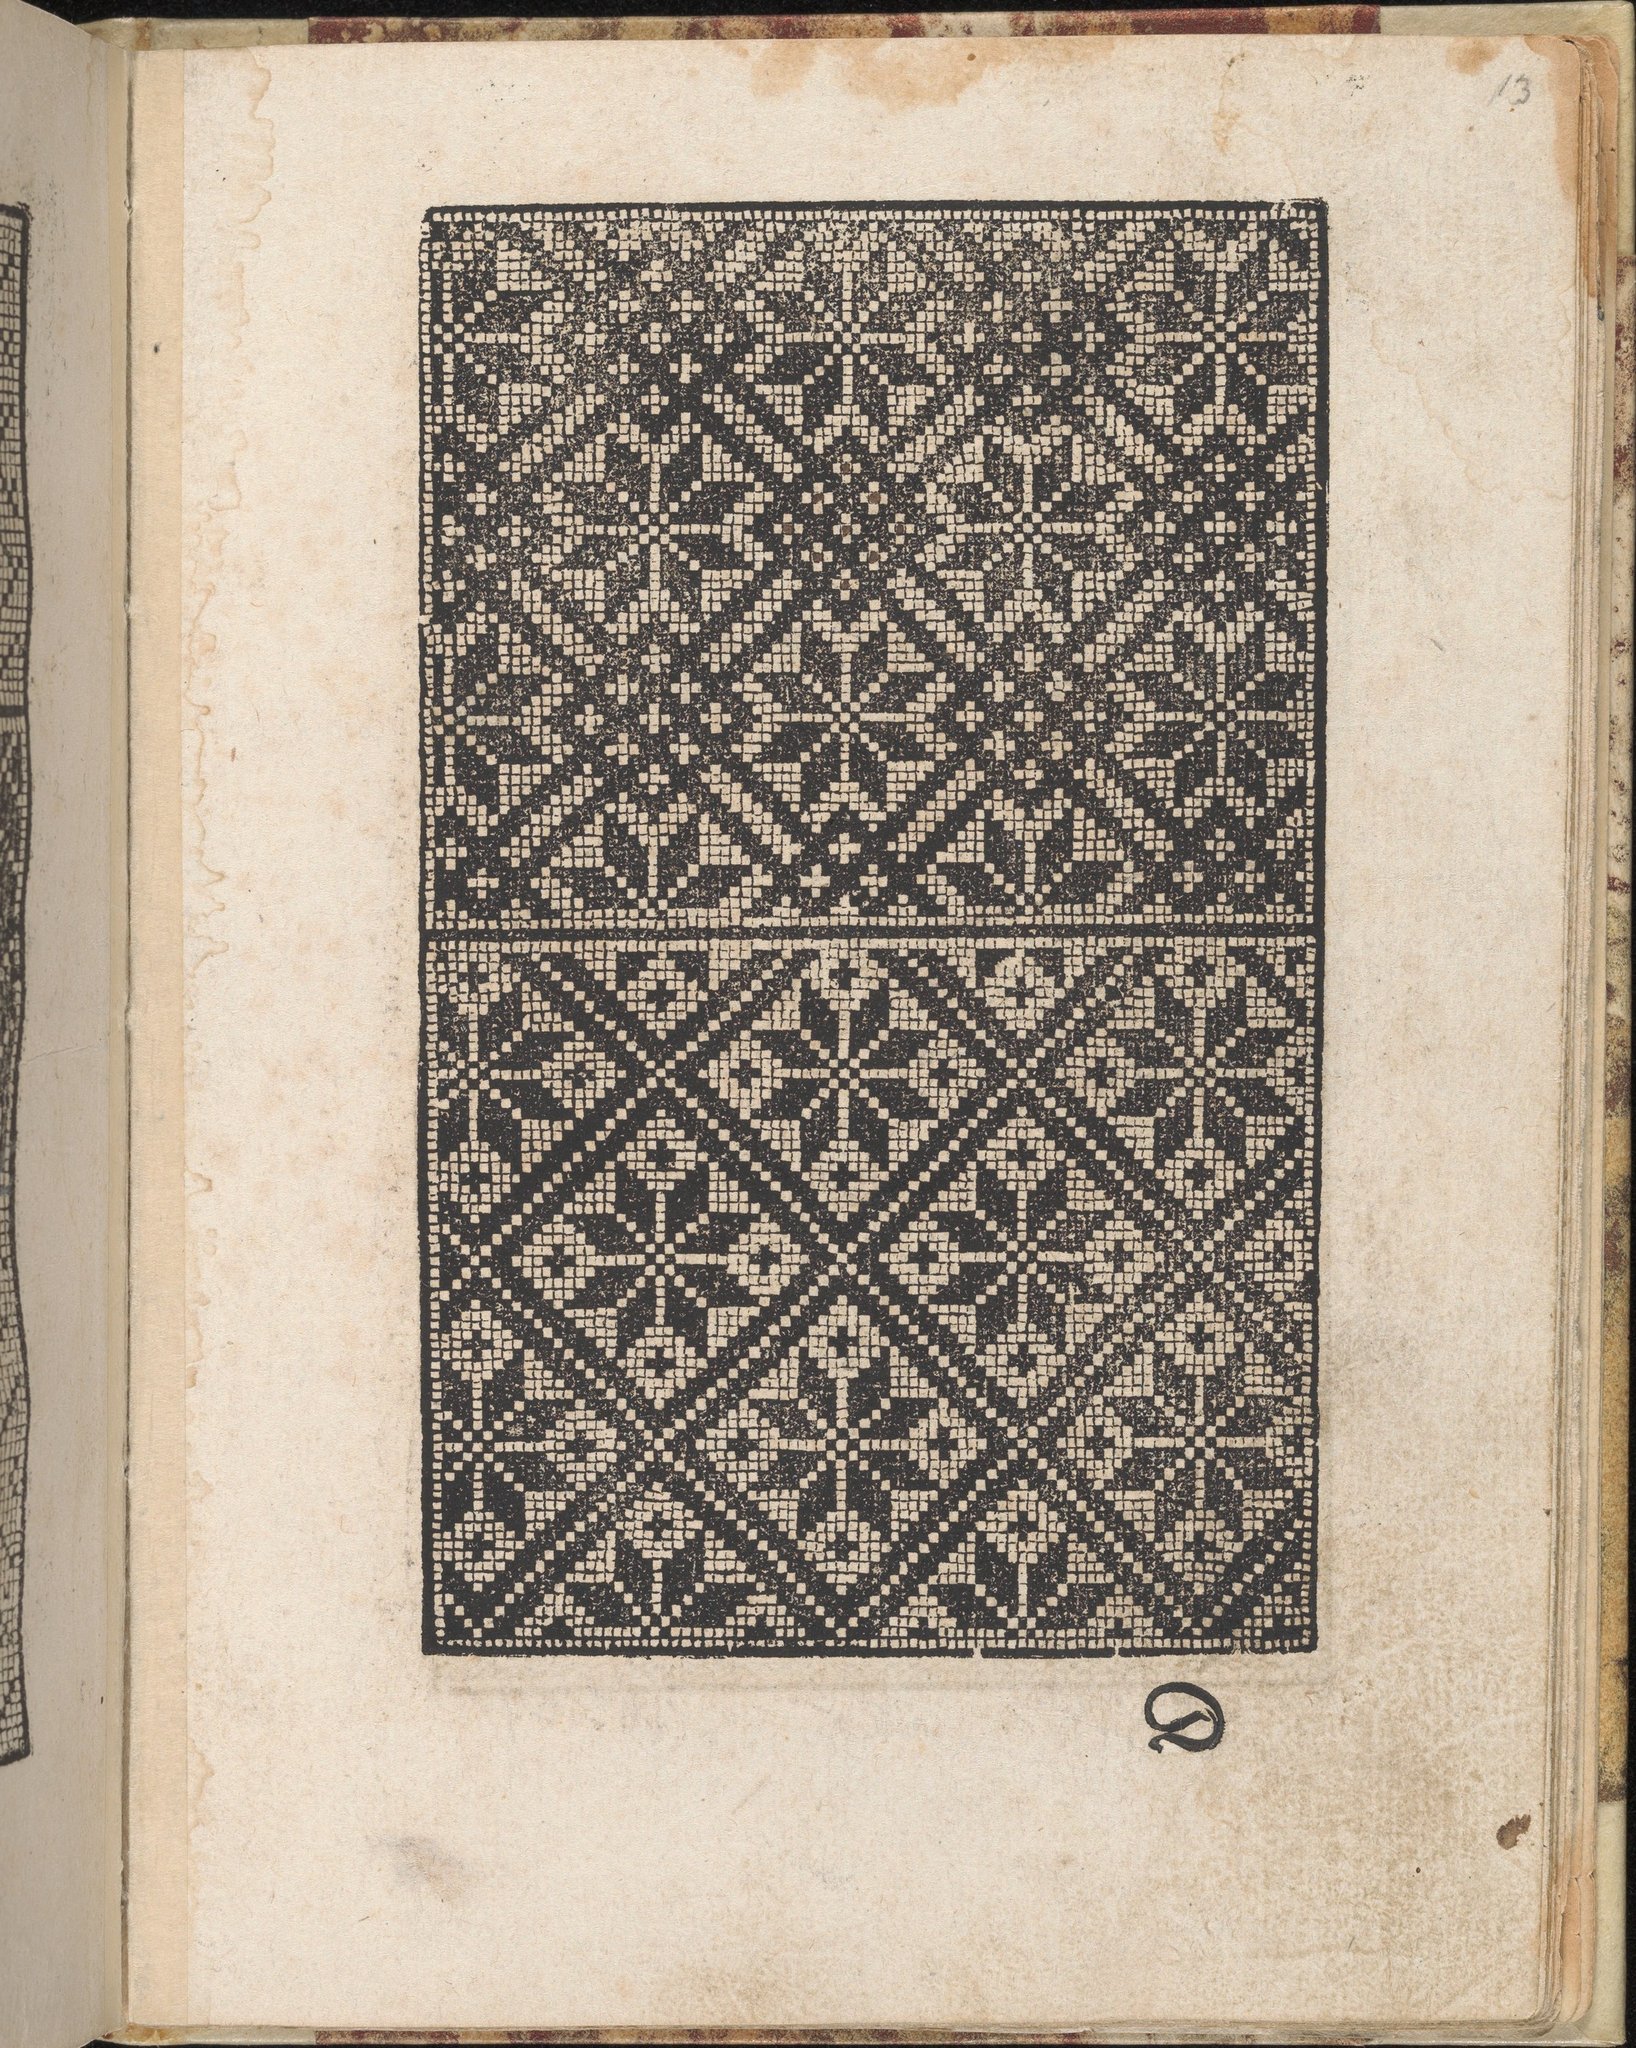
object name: book print ornament architecture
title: Ein new getruckt model Büchli...Page 12, verso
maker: johann schönsperger the younger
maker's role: publisher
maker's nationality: german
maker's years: 1490-1550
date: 1529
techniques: woodcut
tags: ornament